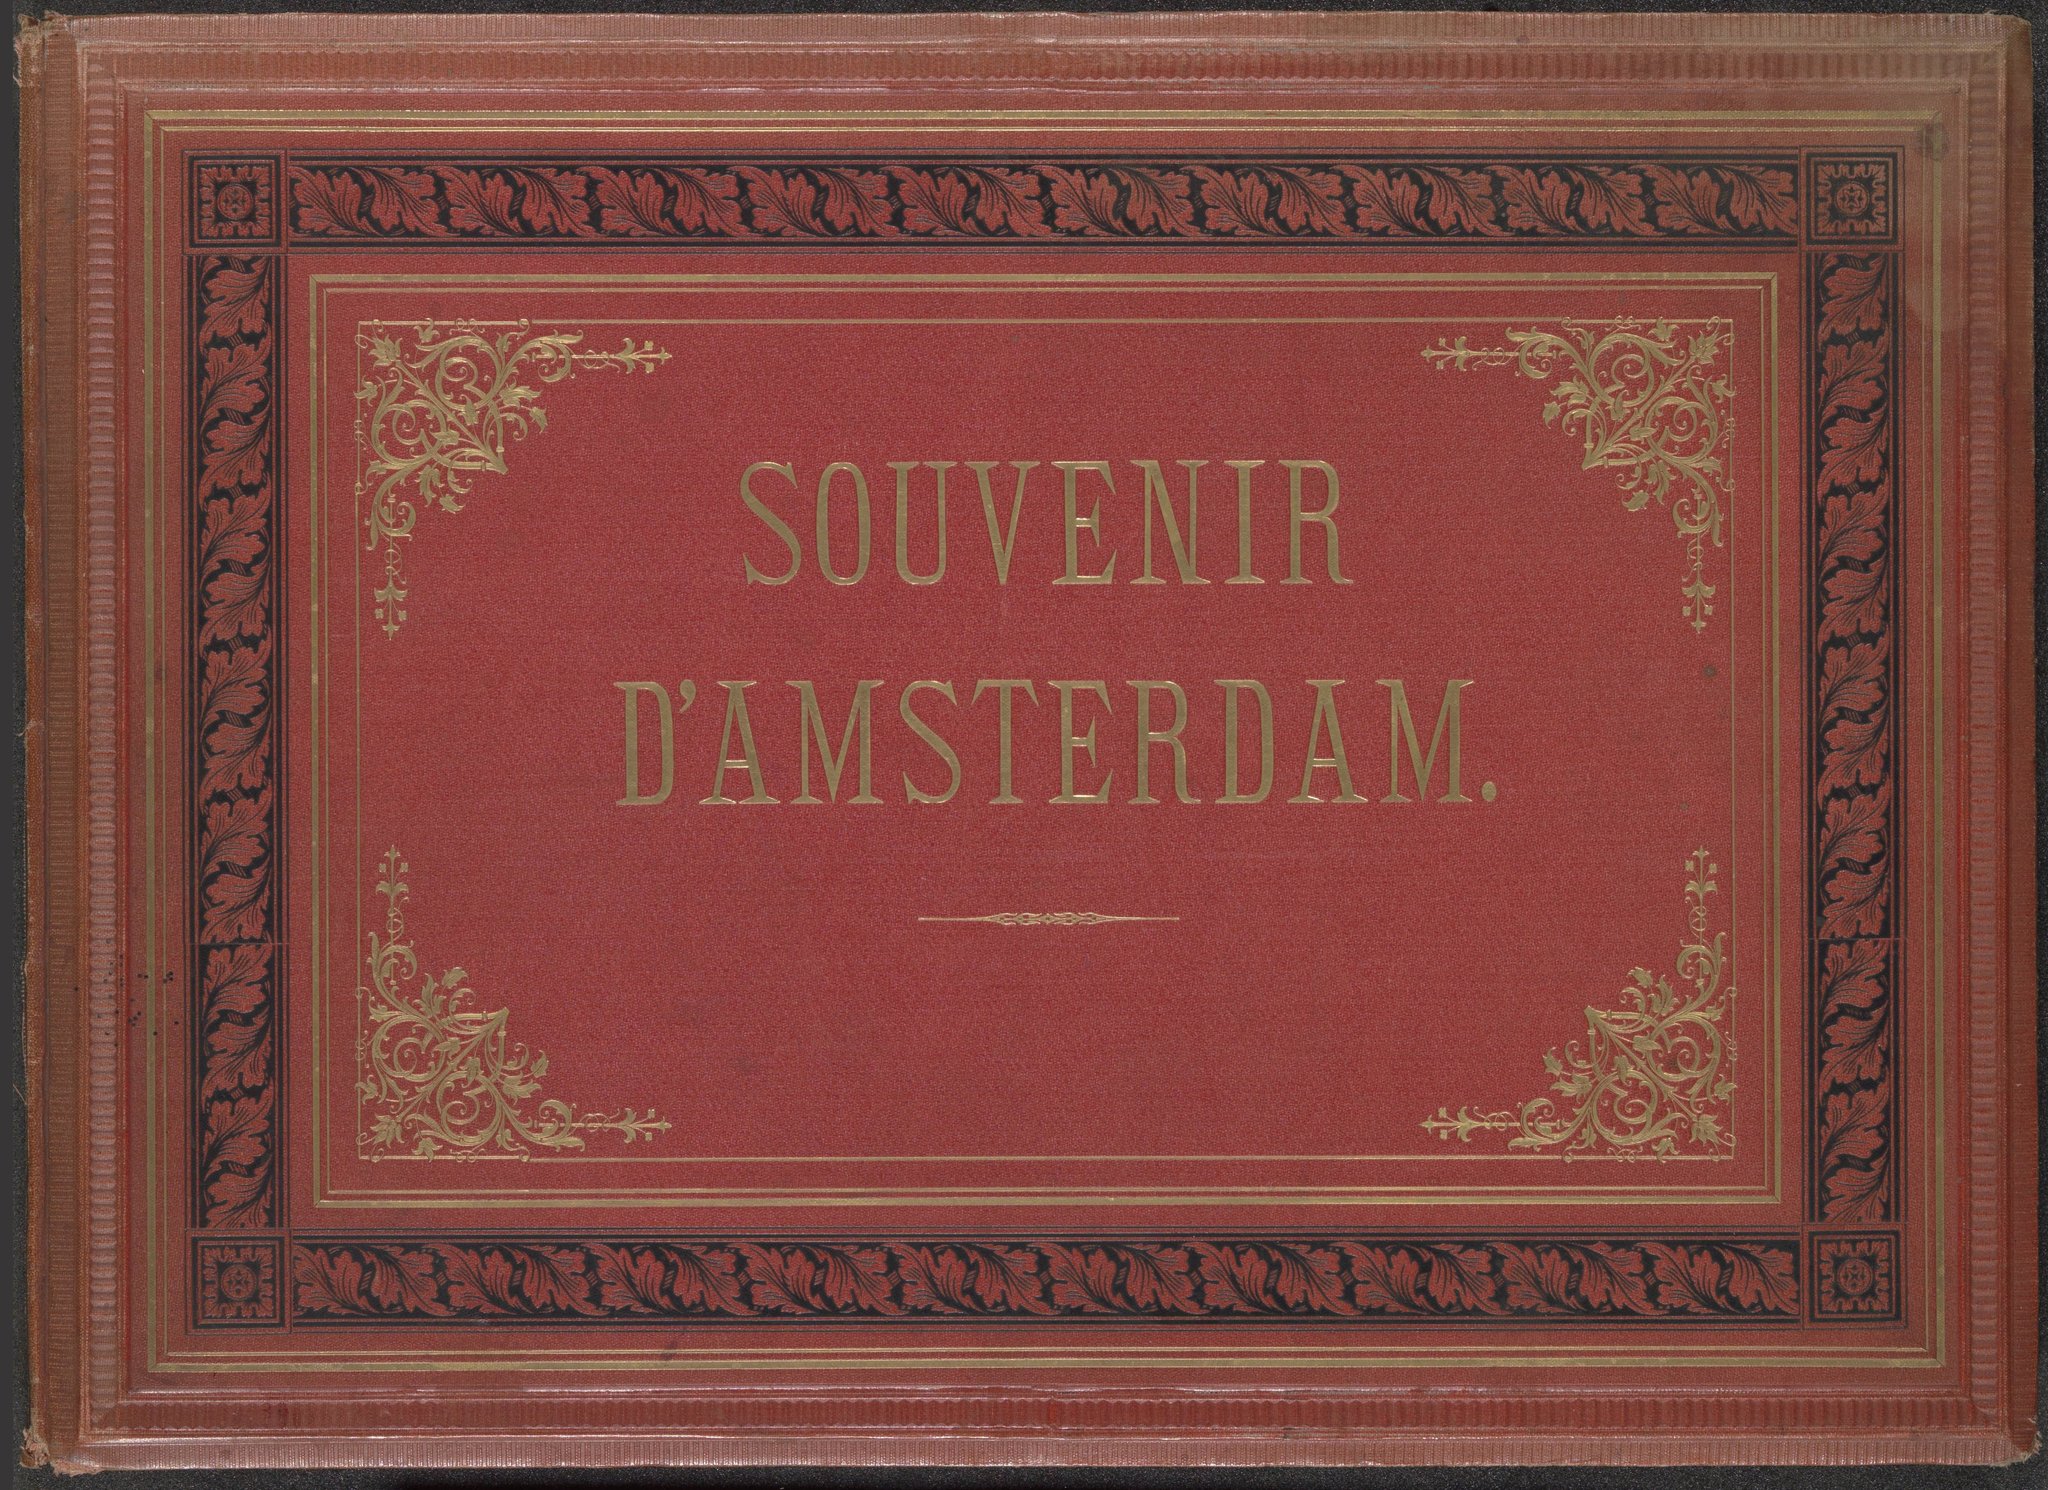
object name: scrapbook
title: Souvenir d'Amsterdam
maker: Anonymous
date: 1880-1900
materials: cardboard, linen, paper, photographic support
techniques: albumen print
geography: amsterdam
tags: travelling; tourism, prospect of city, town panorama, silhouette of city, amsterdam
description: Fotoalbum in rode band. De titel op het voorplat is versierd met plantmotieven in gouddruk en in zwart. De schutbladen hebben een motief van bloemenvazen in groen en zwart. Het album bevat twaalf kartonnen bladen en twaalf foto's, elk met een rood kader. Het zijn stadsgezichten van Amsterdam met Engelstalige onderschriften die vaak letterlijk uit het Nederlands vertaald zijn ('Gentlemans canal' voor Herengracht etc.). In beeld zijn onder andere gebracht: het Koninklijk Paleis, de Beurs van Zocher, de Waag op de Nieuwmarkt, de Montelbaanstoren, het Rijksmuseum, het Amstel Hotel en de Nicolaaskerk.